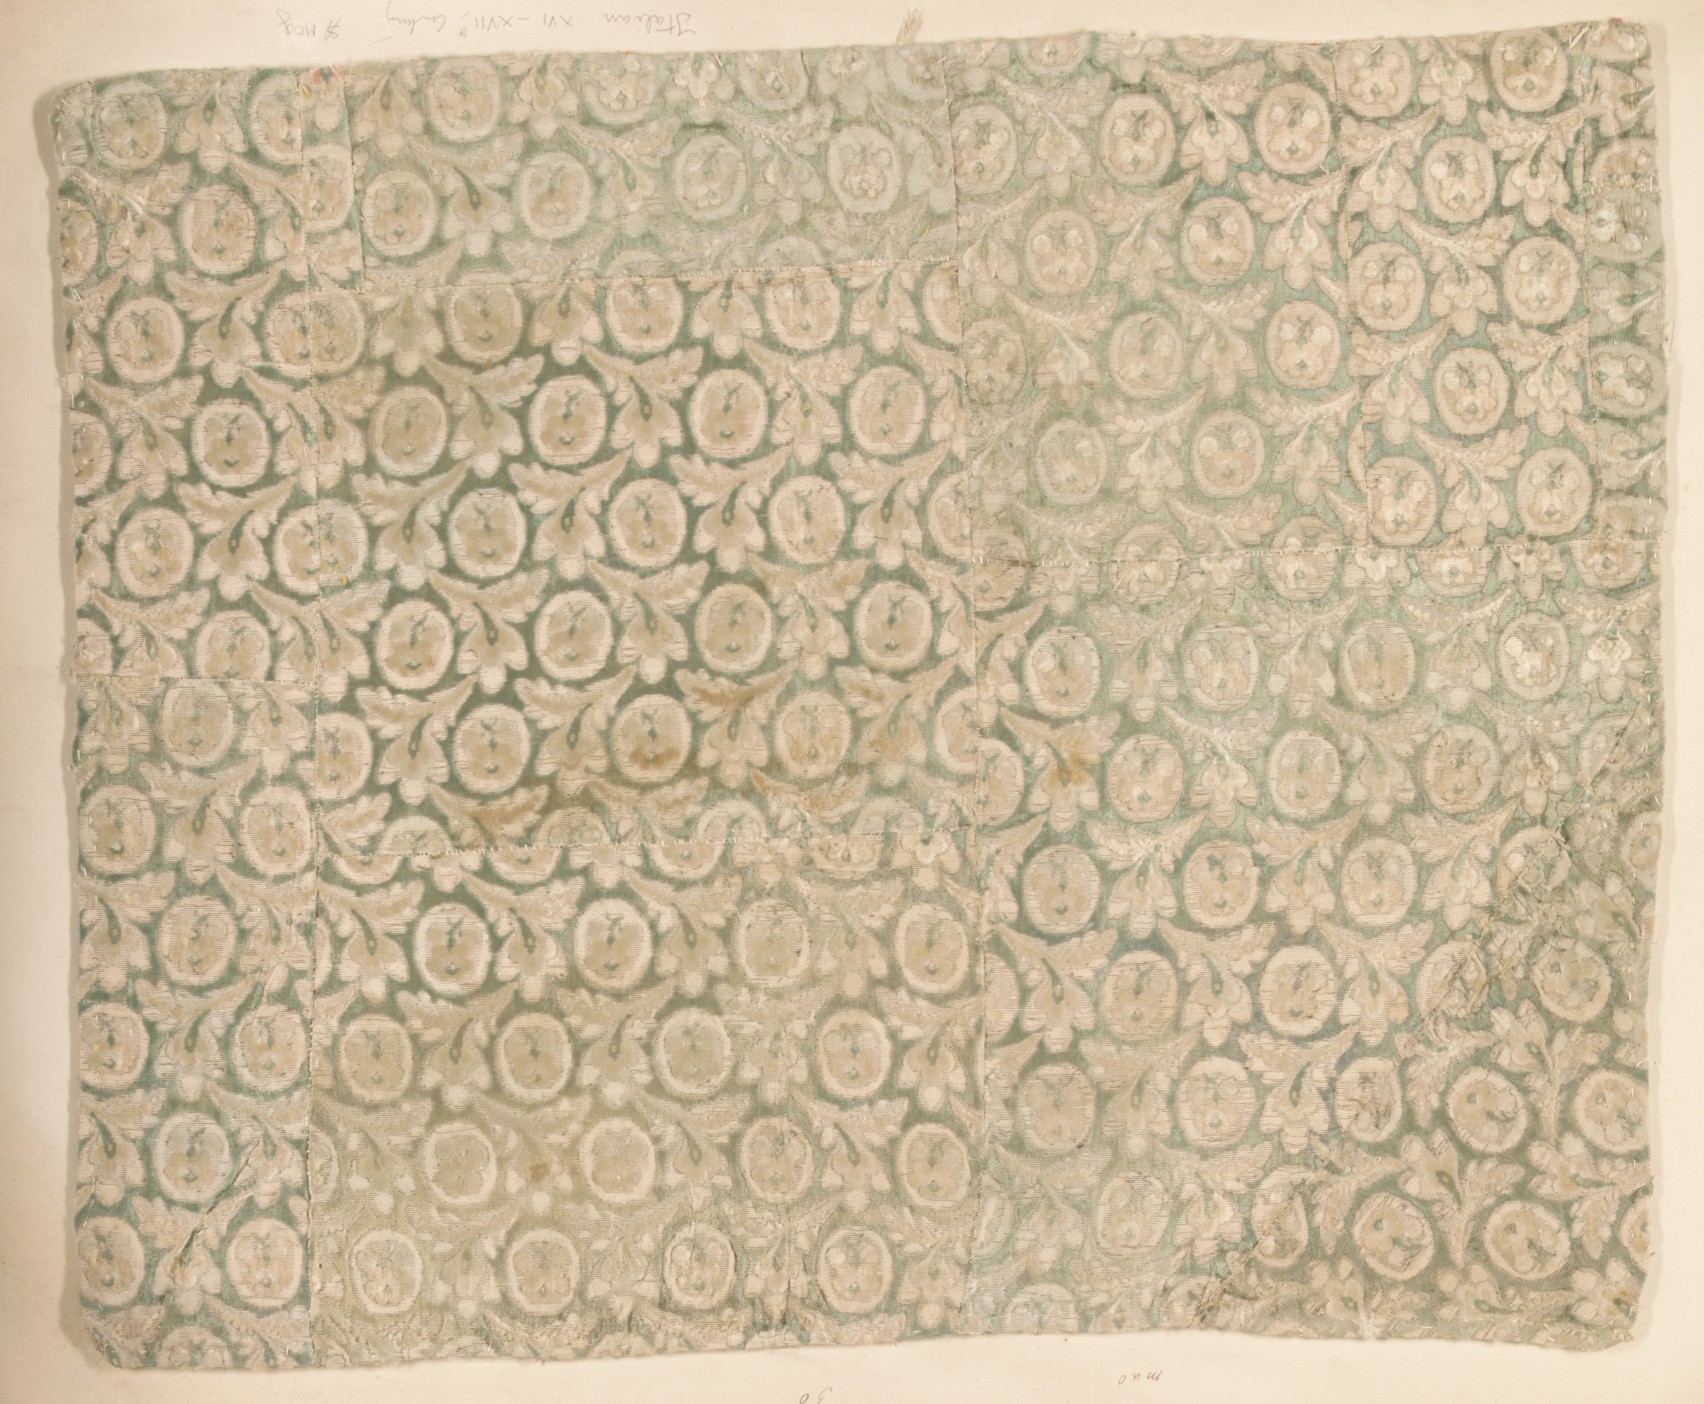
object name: fragment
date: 1501-1700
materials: metal thread, silk